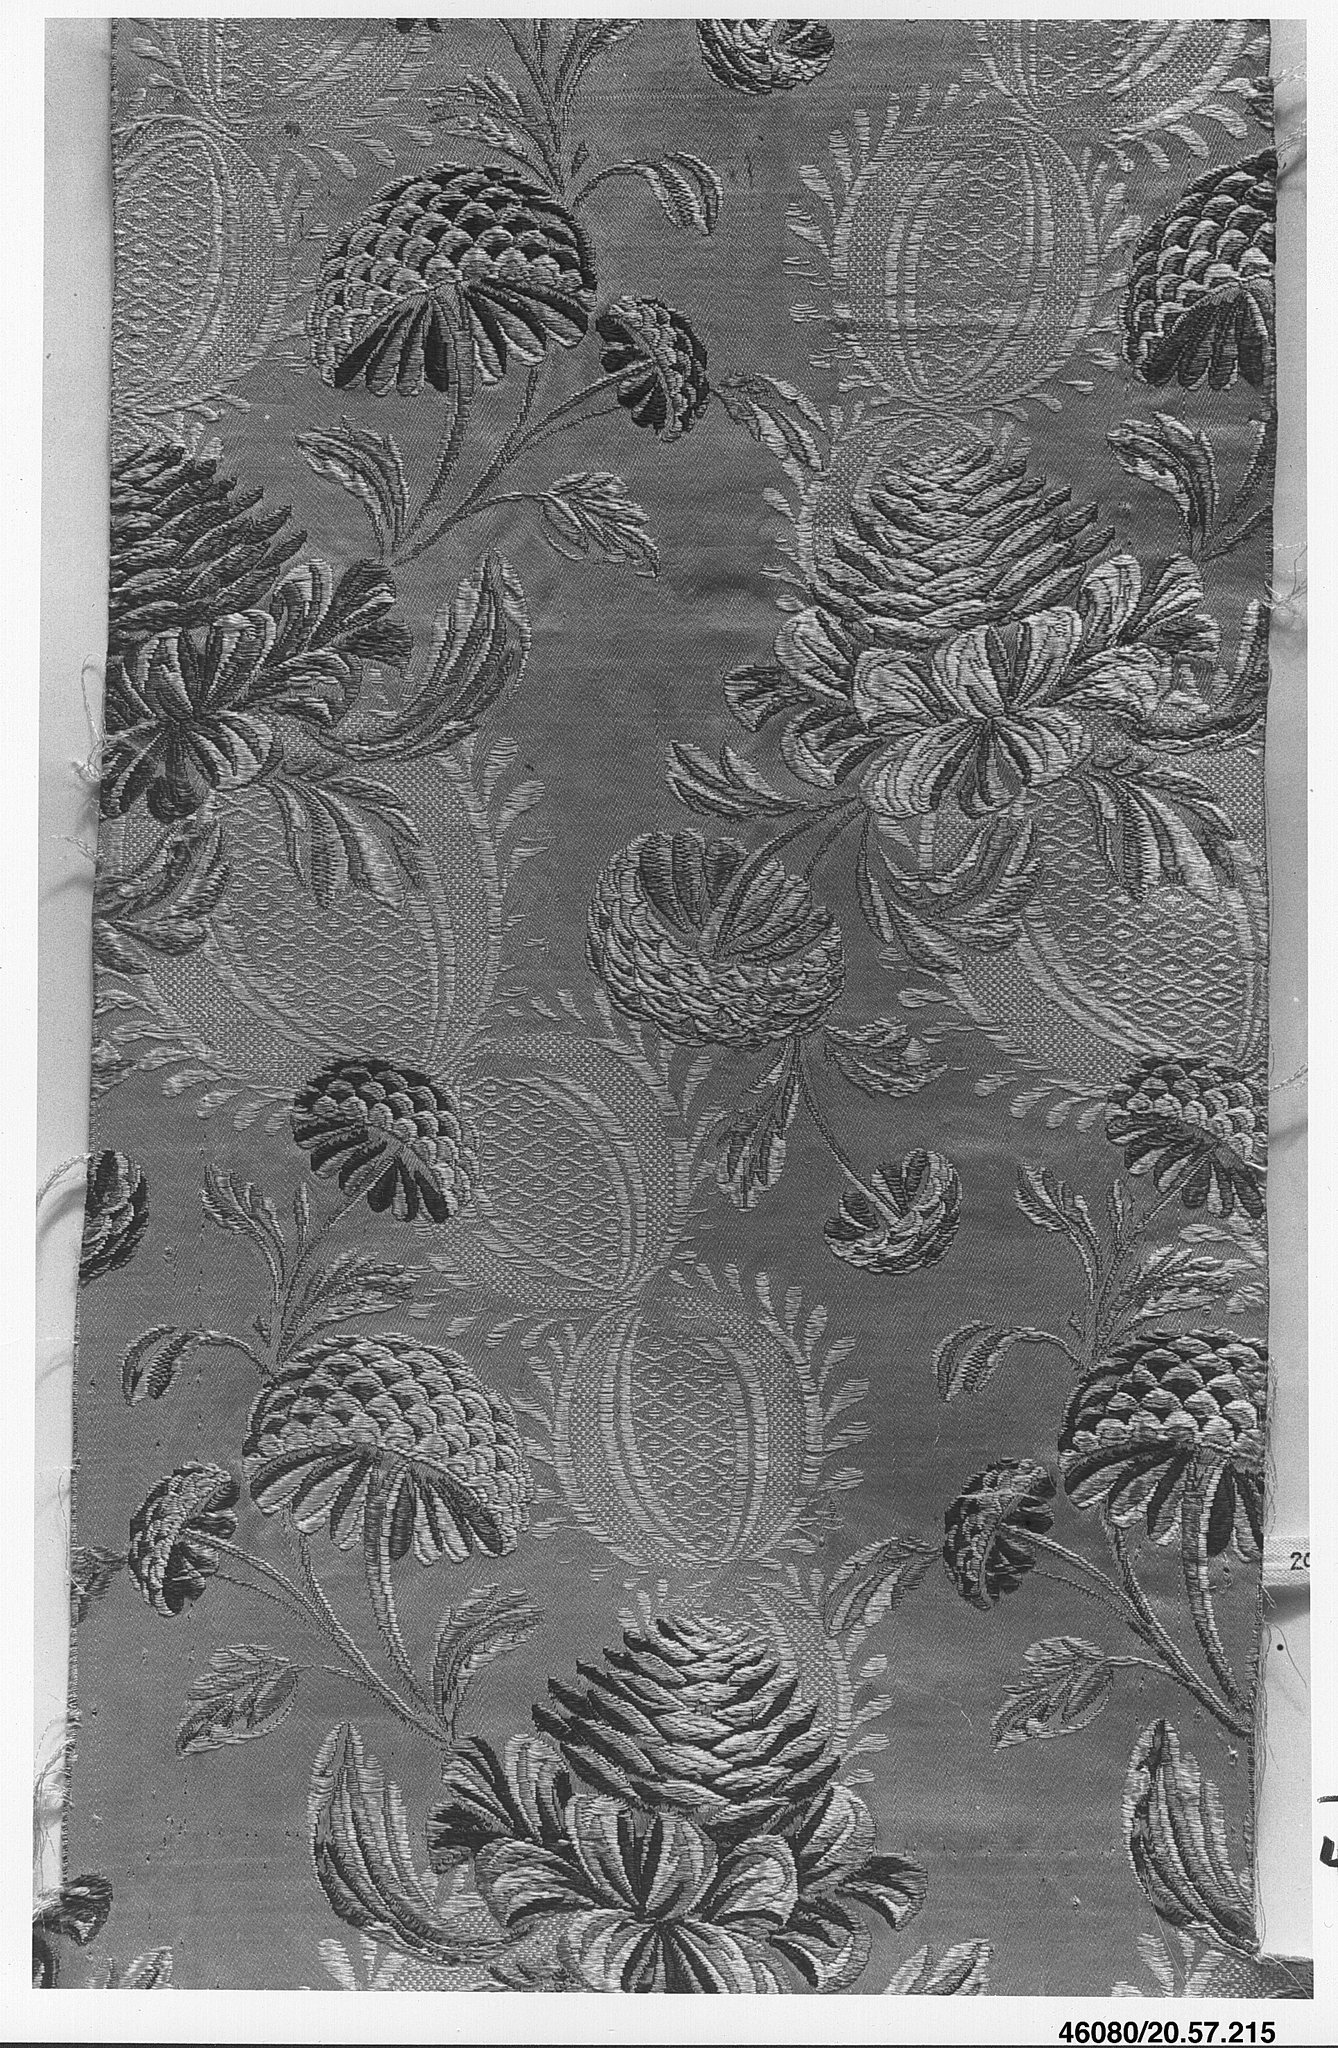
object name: piece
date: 1801-1900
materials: silk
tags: flowers,leaves